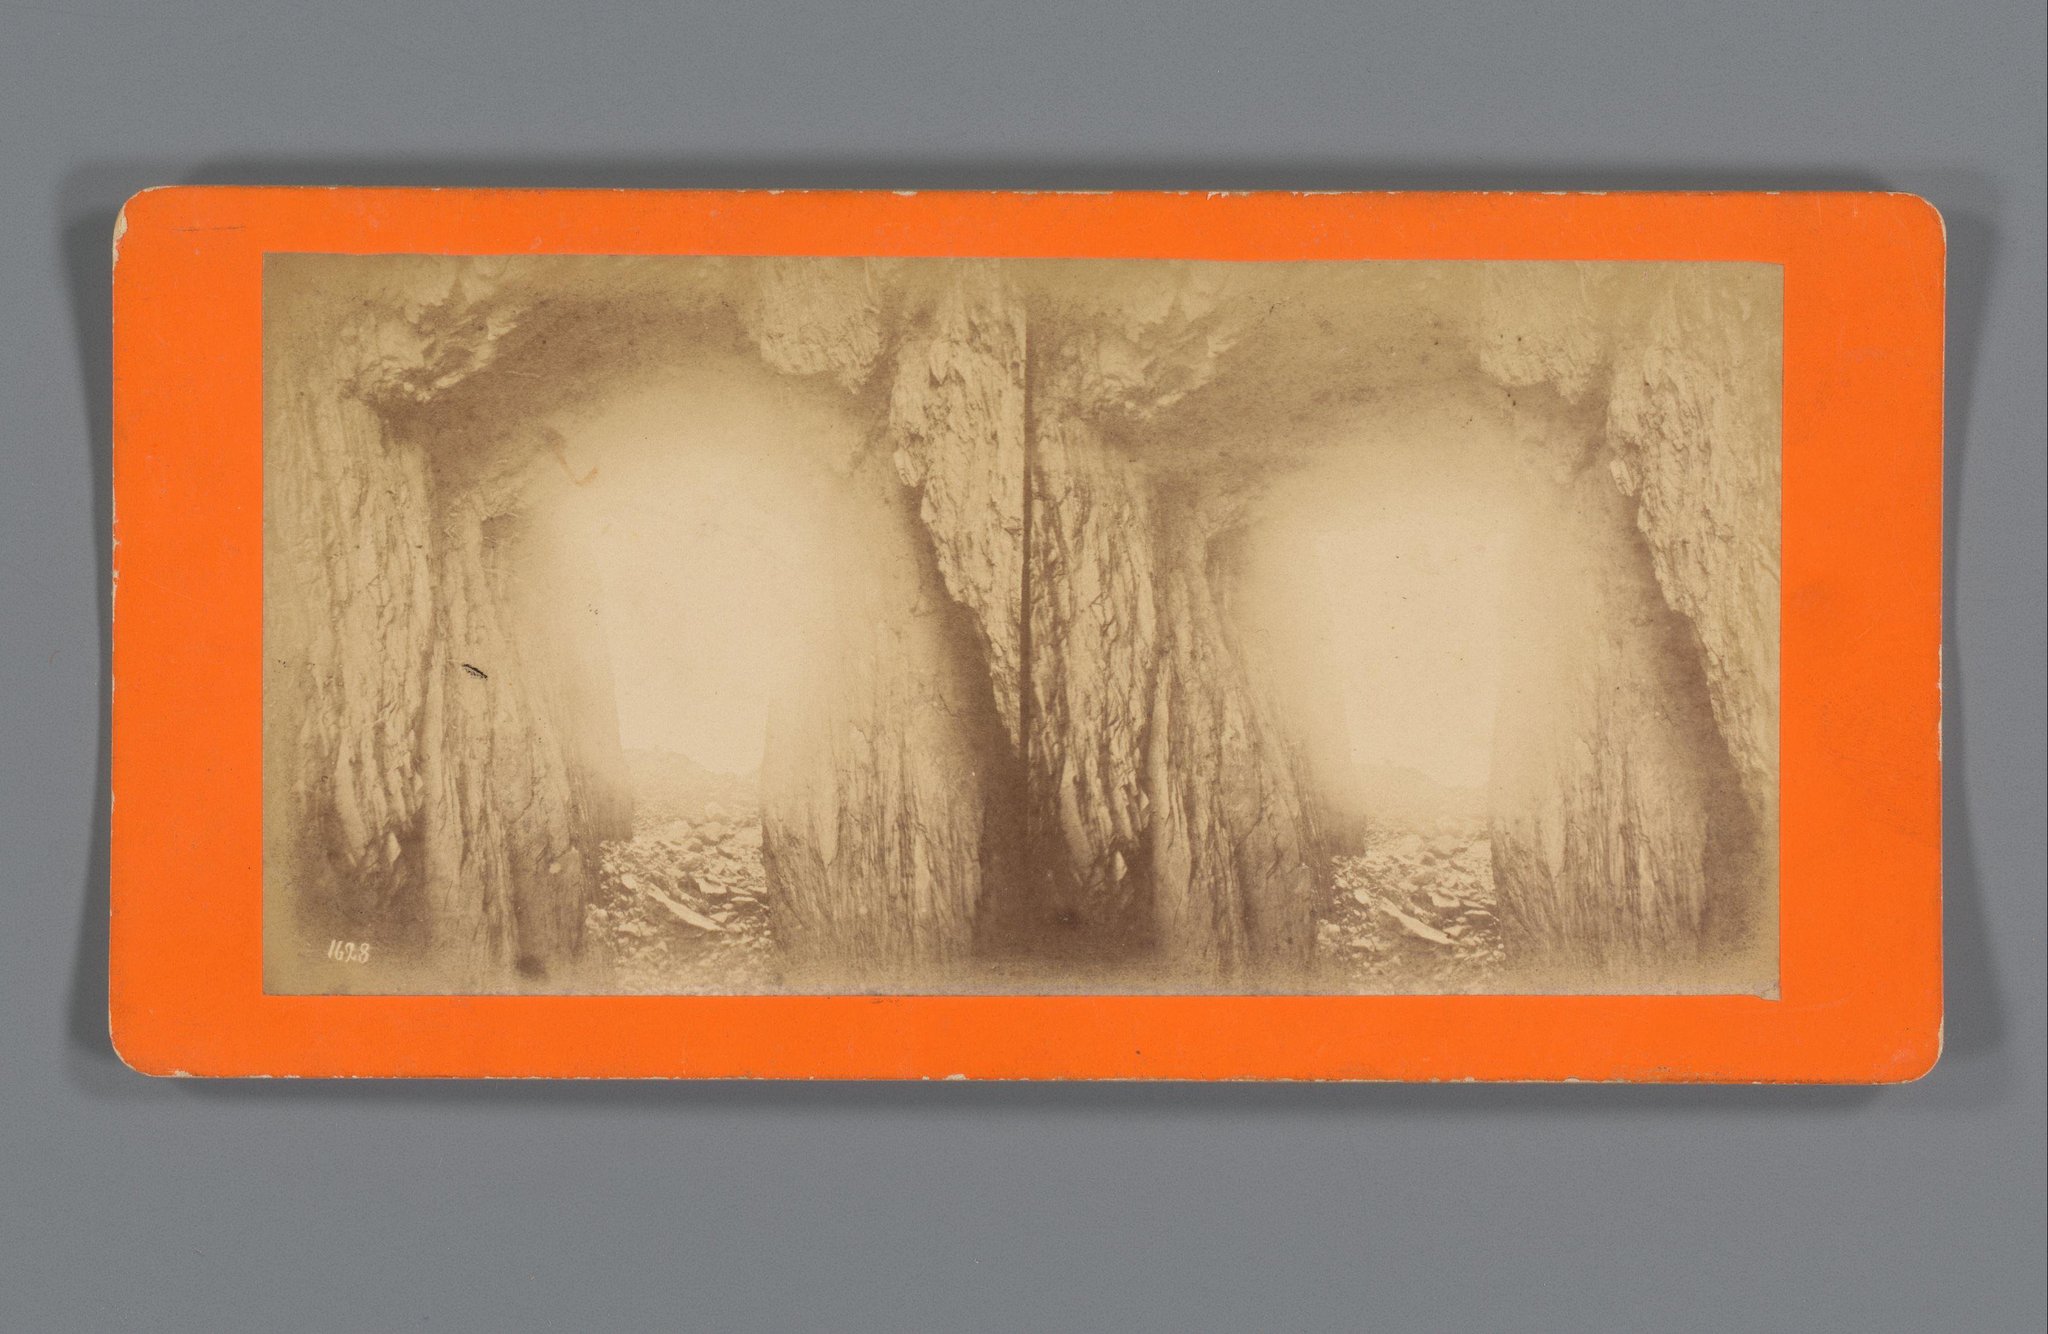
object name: stereograph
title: Parti af Torghatten, Nordland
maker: knud knudsen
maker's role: fotograaf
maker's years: 1832-1915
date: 1873-1890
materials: cardboard, paper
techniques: albumen print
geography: torget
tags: island, rock-formations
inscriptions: number: ‘1628’, inscription: ‘Torghatten Norvège’